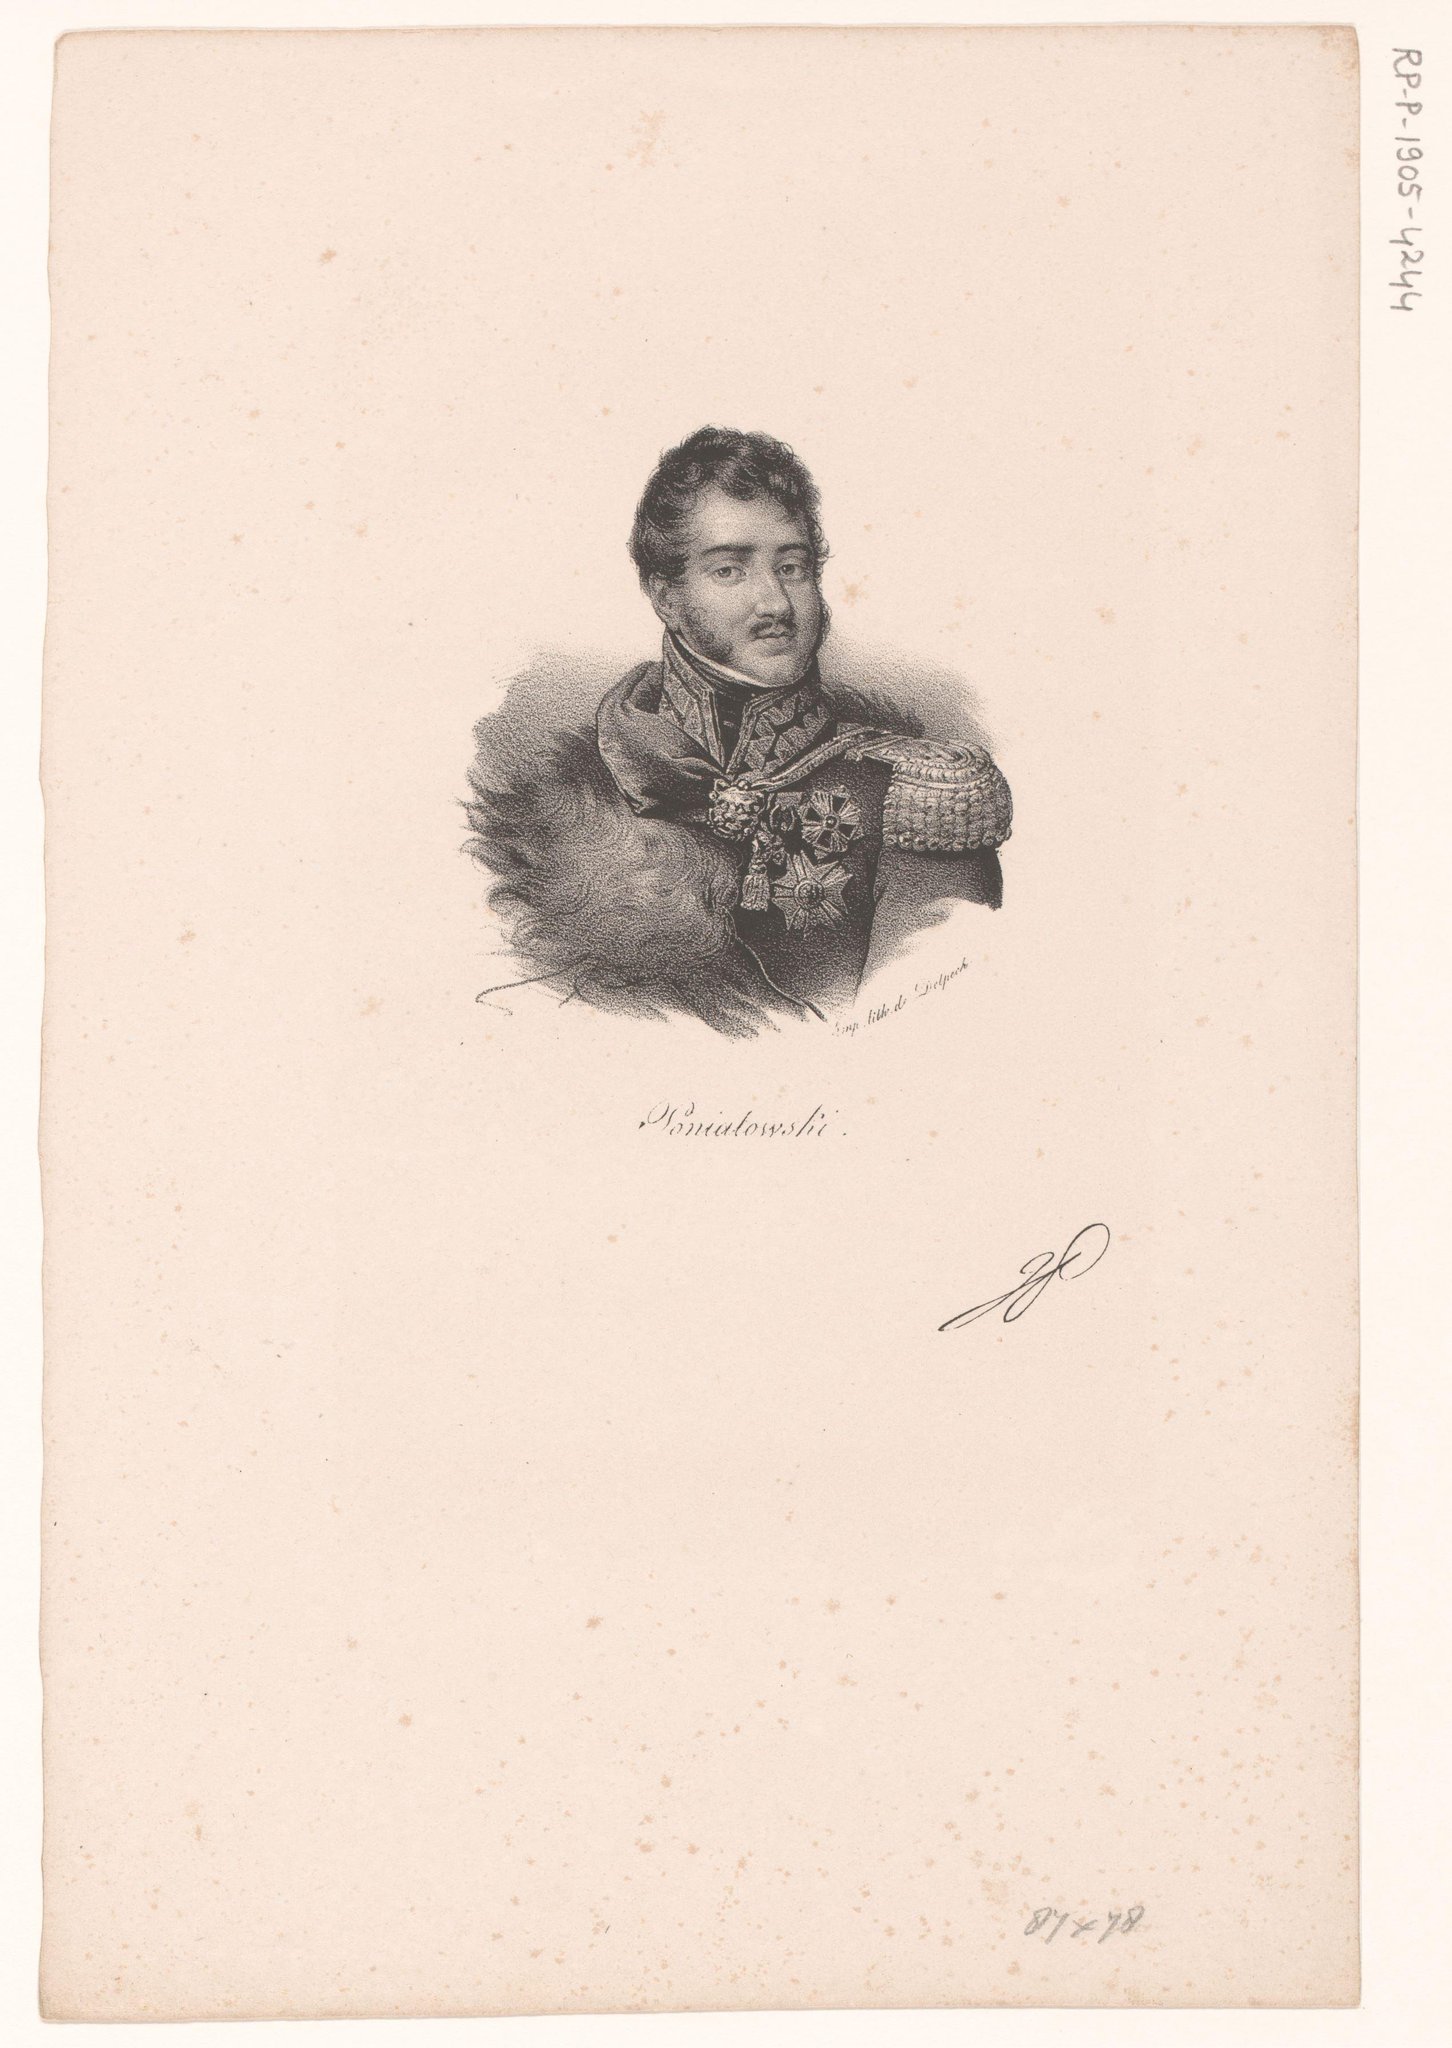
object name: print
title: Poniatowski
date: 1818-1842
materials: paper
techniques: lithograph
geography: paris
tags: historical persons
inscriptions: collector's mark: Lugt 2228a